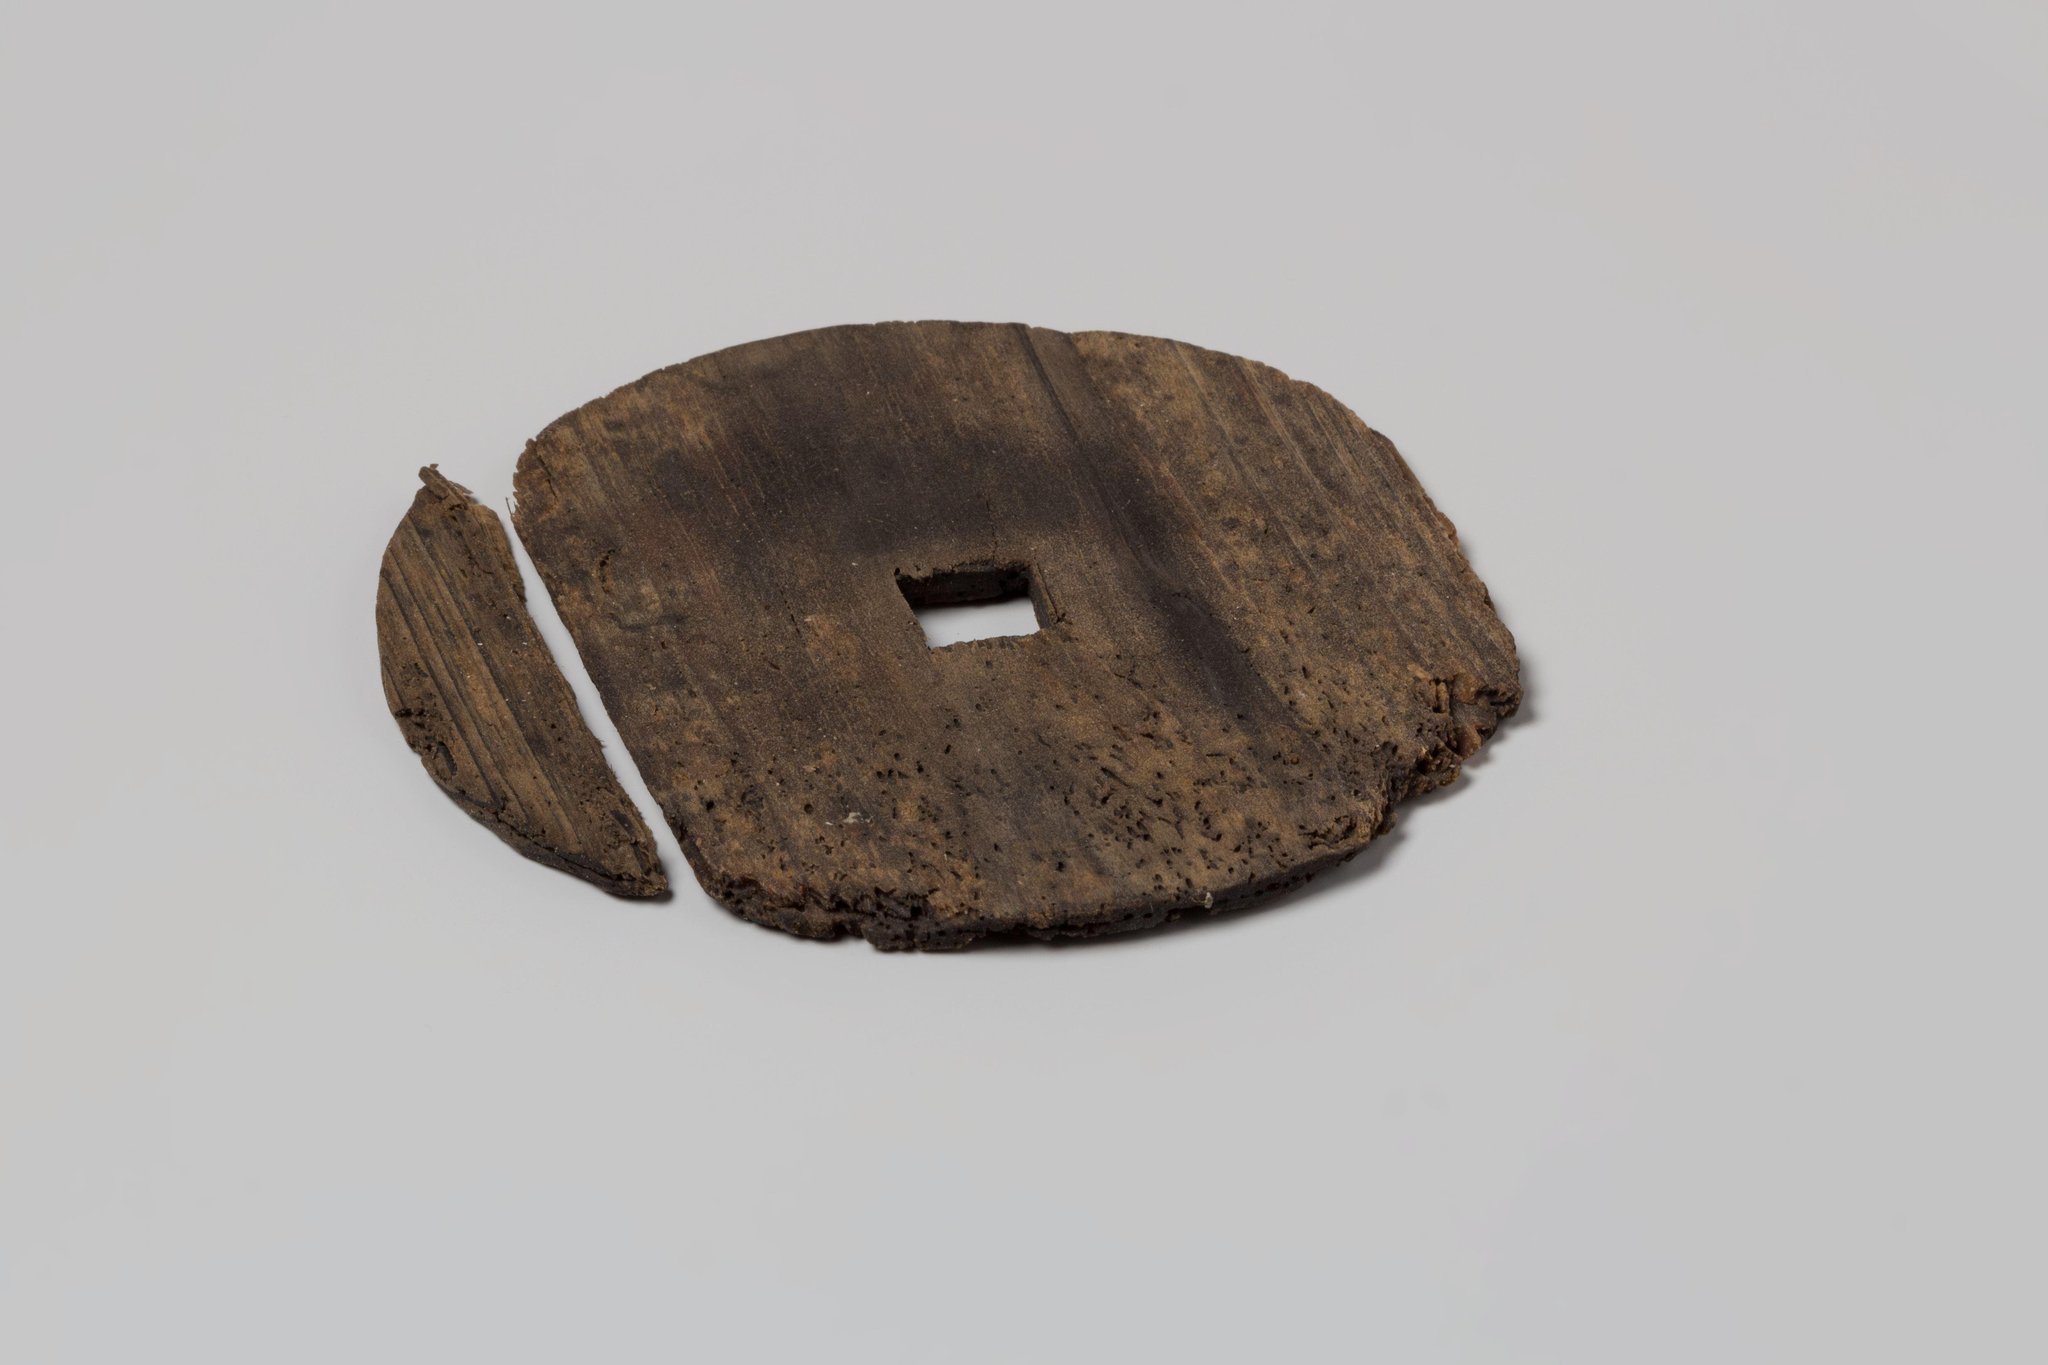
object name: disk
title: Schijf voor verpakking uit V.O.C.-schip de 'Witte Leeuw'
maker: Anonymous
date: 1613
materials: wood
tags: verenigde oostindische compagnie, sint-helena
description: Schijf voor verpakking uit V.O.C.-schip de 'Witte Leeuw'. In het midden zit een vierkant gat. De schijf is in tweeën gespleten en mist een klein deel.